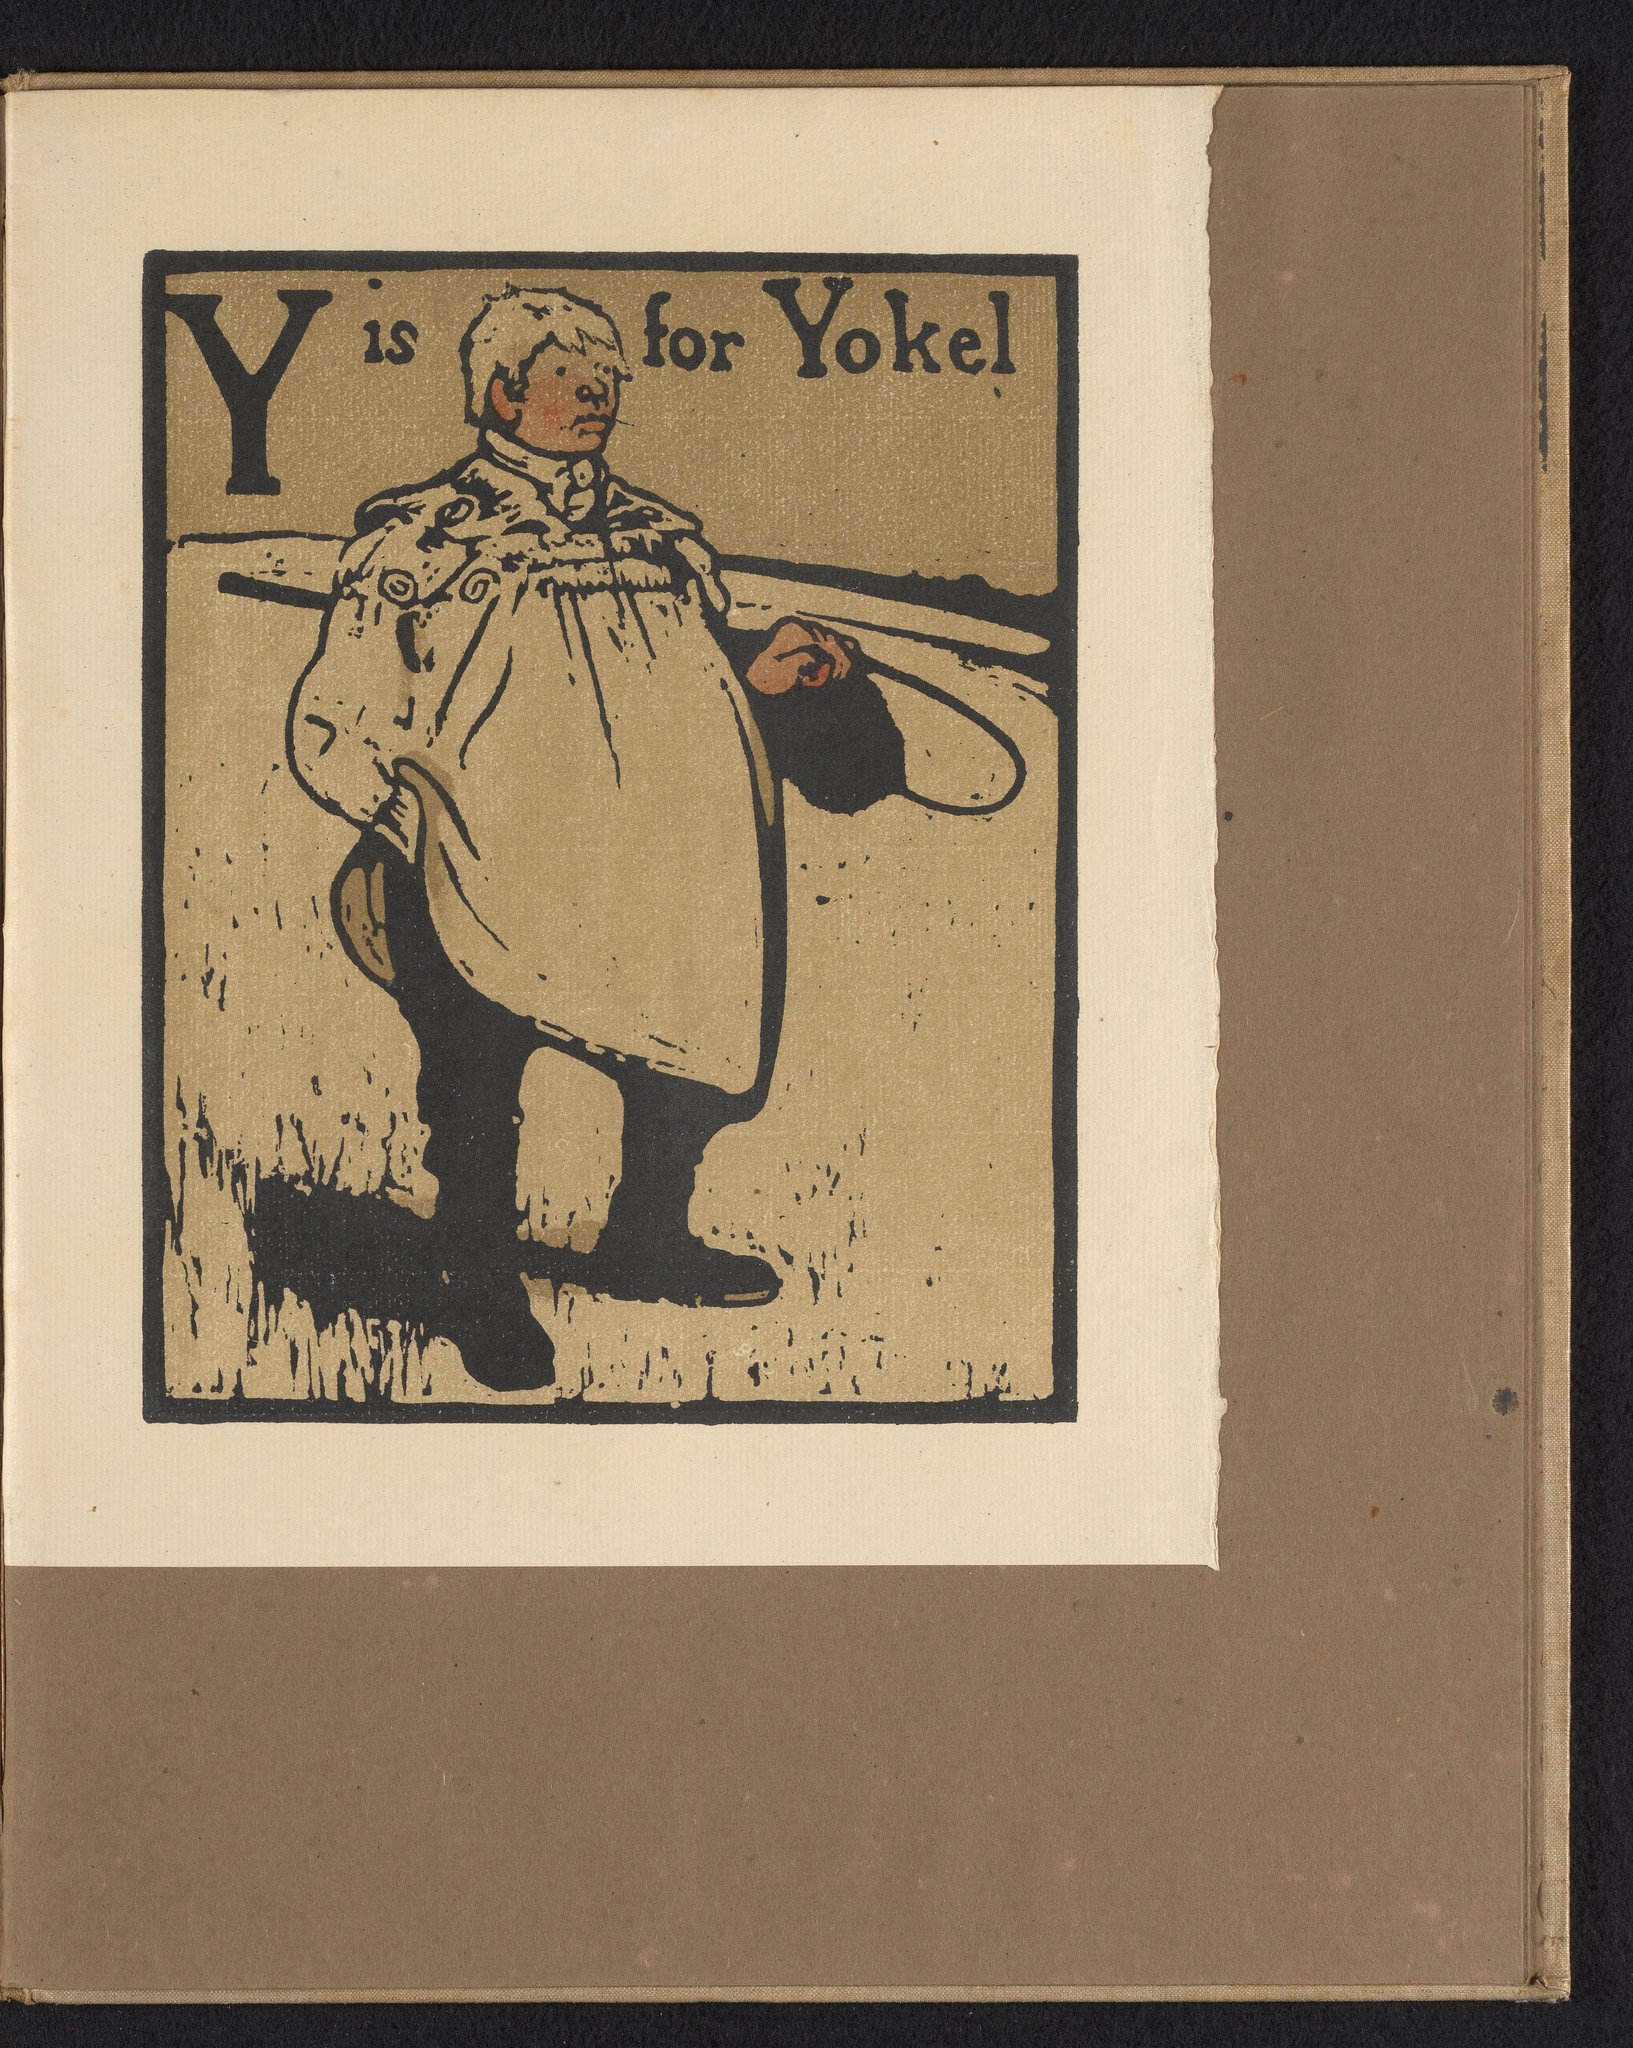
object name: page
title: An Alphabet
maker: william heinemann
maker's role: publisher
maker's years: 1863-1920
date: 1898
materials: paper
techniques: lithograph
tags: adult man, farmers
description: De serie met lithografieën is gemaakt naar ontwerpen van houtsneden door William Nicholson.